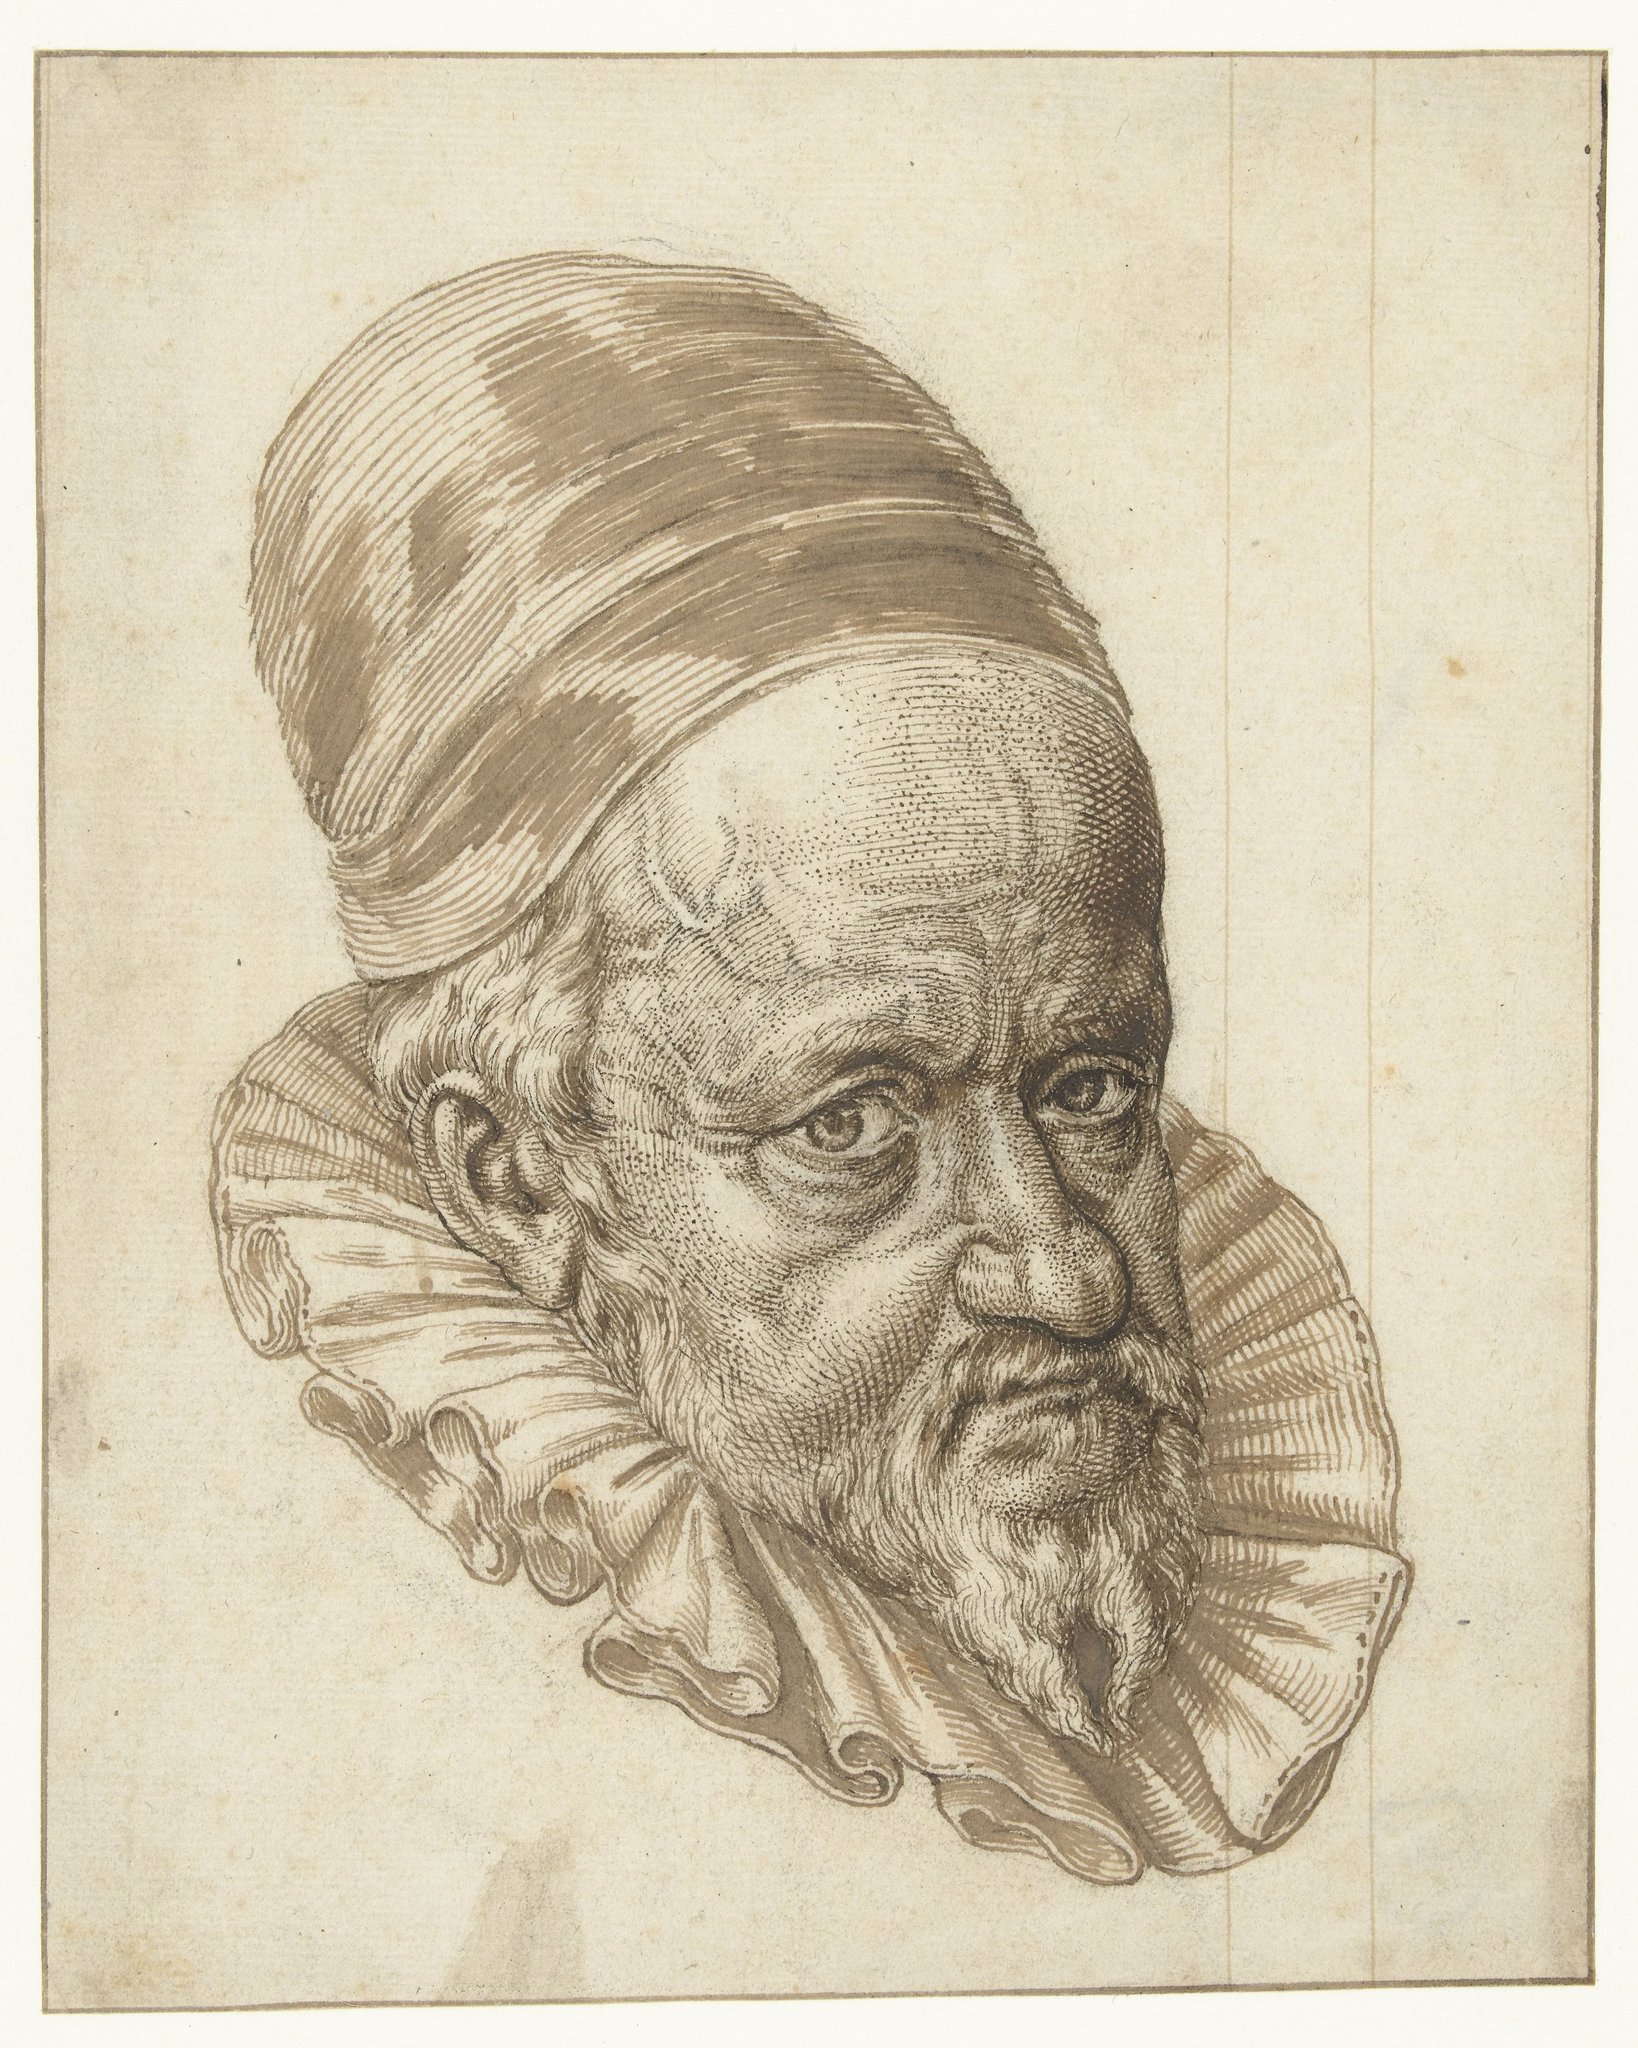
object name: drawing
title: Portret van Sigismund Feyerabend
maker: theodor de bry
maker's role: draughtsman, print maker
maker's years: 1528-1598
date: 1595-1598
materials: ink, paper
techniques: pen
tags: print maker, printer, publisher, bookseller, sigmund feyerabend, portrait, self-portrait of artist, historical persons not known by name